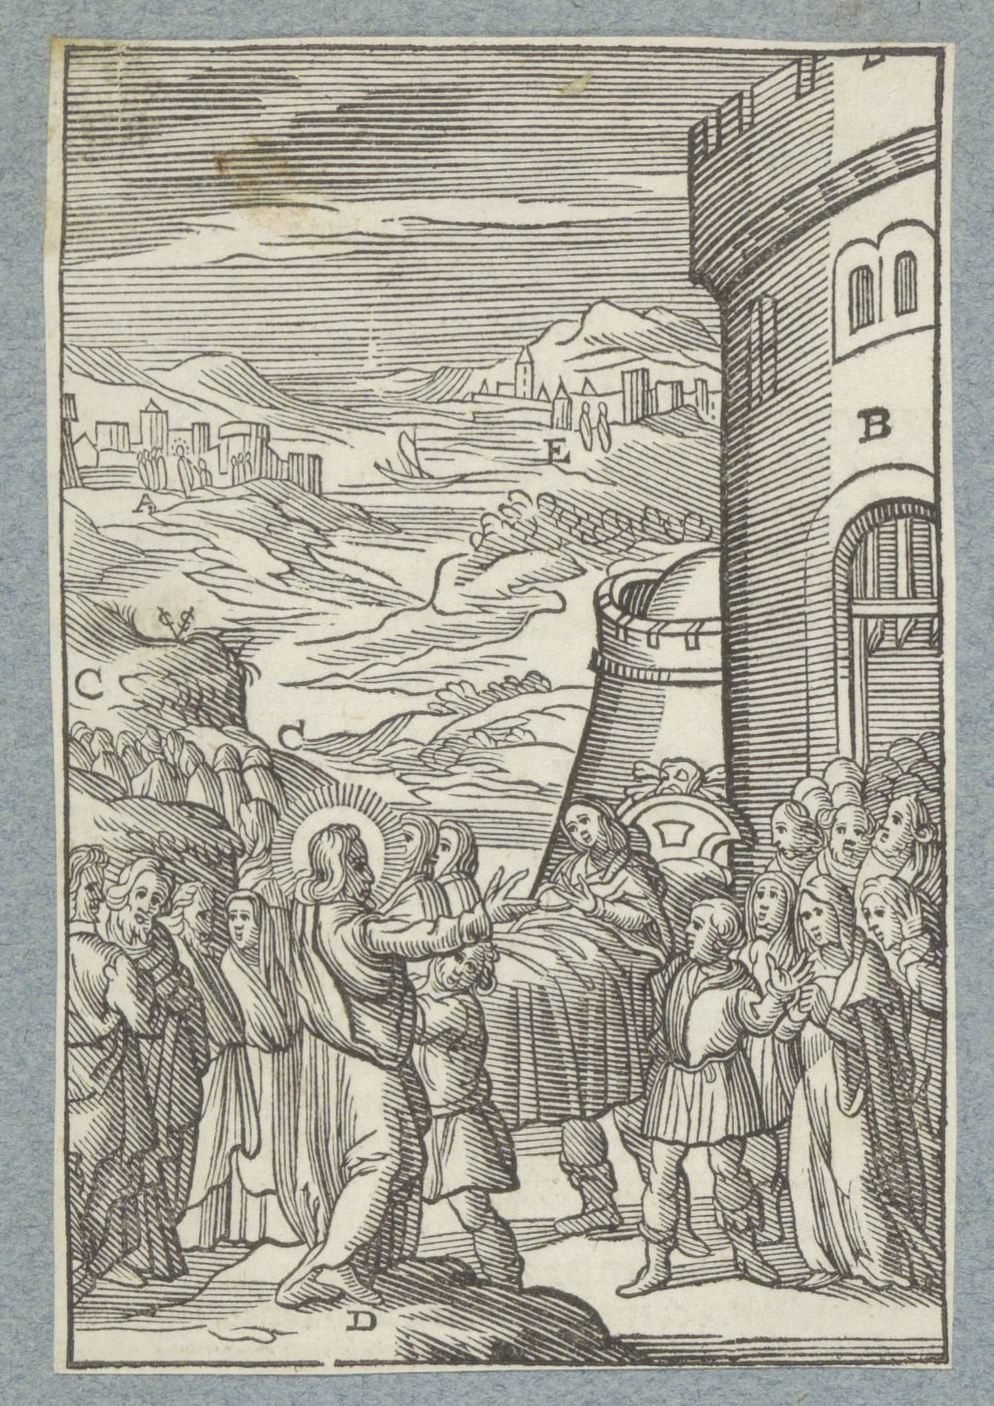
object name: album leaf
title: Opwekking van de zoon van de weduwe van Naïn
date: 1629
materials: paper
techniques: letterpress printing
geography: amsterdam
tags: christ touches the bier of the son of the widow of nain: the young man sits up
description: De prent is afkomstig uit een van de uitgaven van P.J. Paets uit Amsterdam. De prent wordt voor het eerst gebruikt in: Der Zielen Lust-hof. Leuven, I.Jacbosz voor P.J. Paets [= Amsterdam, P.J. Paets], 1629. De voorstelling is gekopieerd naar een prent van Karel van Mallery voor: Nadal, Jerónimo. Evangelicae Historiae Imagines. Antwerpen, M. Nutius, 1593.